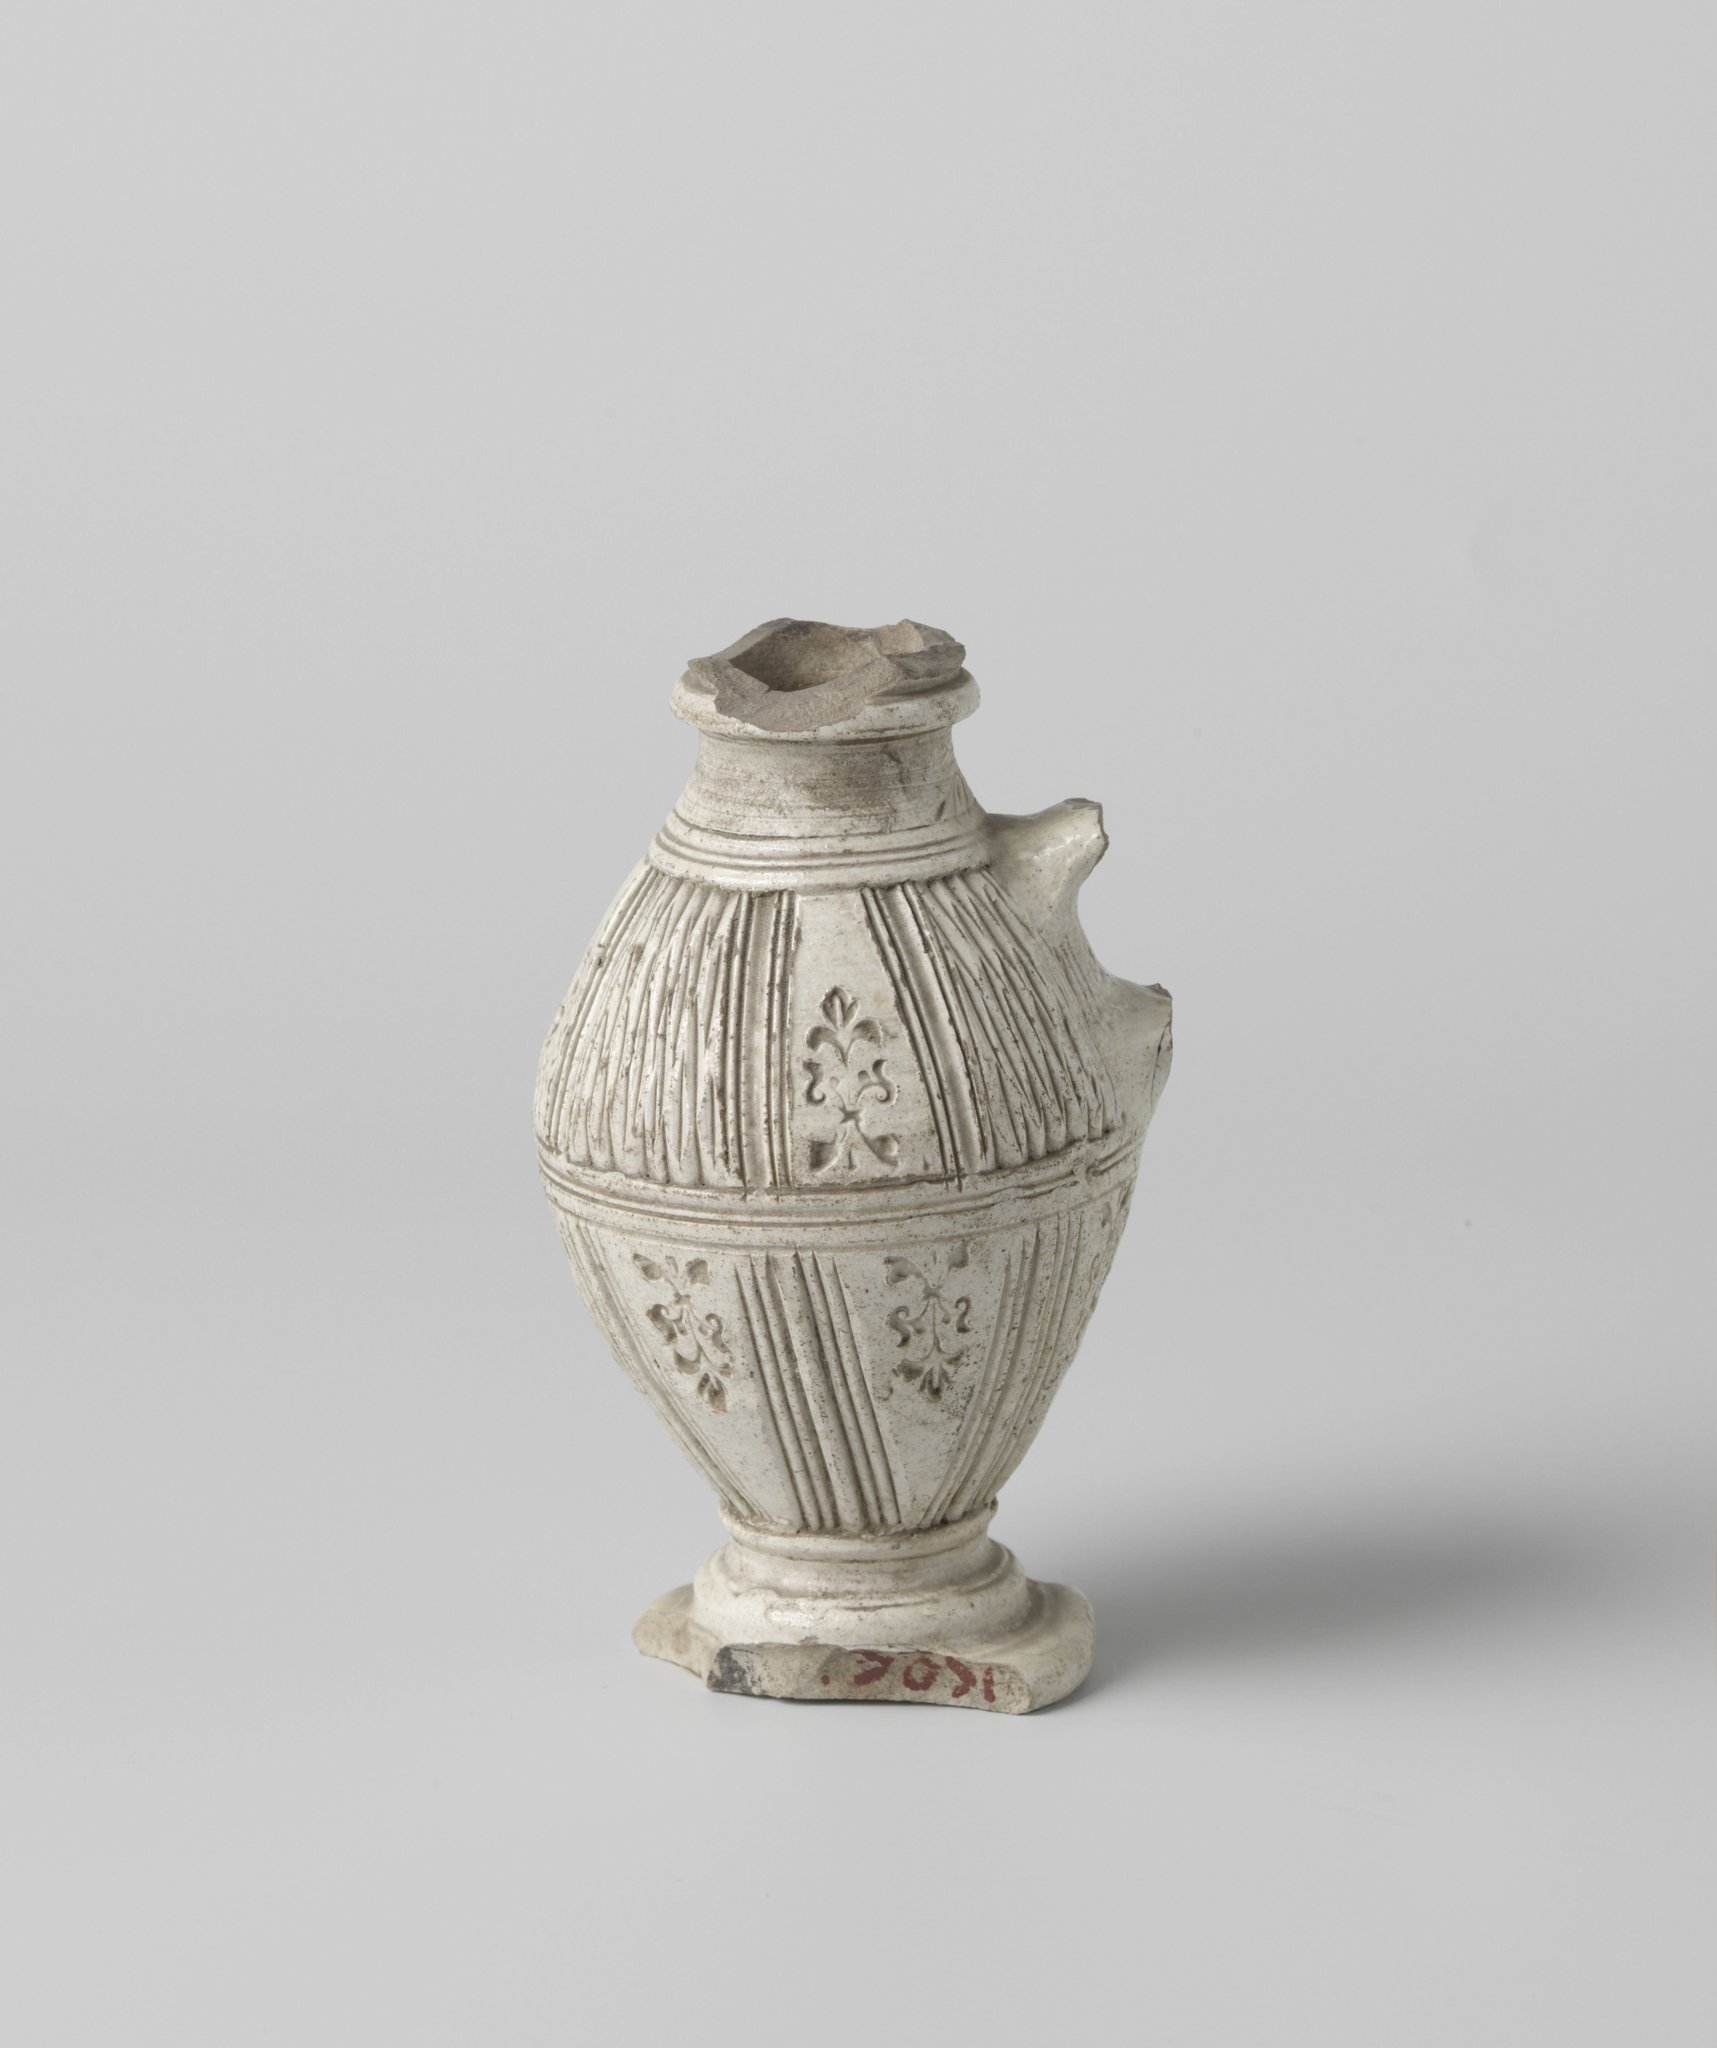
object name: jug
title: Fragment of a jug with chip carving and stylized floral scrolls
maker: Anonymous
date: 1500-1699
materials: glaze, stoneware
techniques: printing, firing, forming, turning, vitrification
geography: germany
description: Fragment van een kruik (trechterhalsbeker?) van steengoed op hoge voet met een eivormig lichaam en smalle nek. Het oor en een deel van de nek ontbreken. Profielen op de nek en voet. De buik is verdeeld in twee banden met ingegrifte vakken. De vakken zijn afwisselend gevuld met kerfsnede of een gestempelde, gestileerde bloemrank.